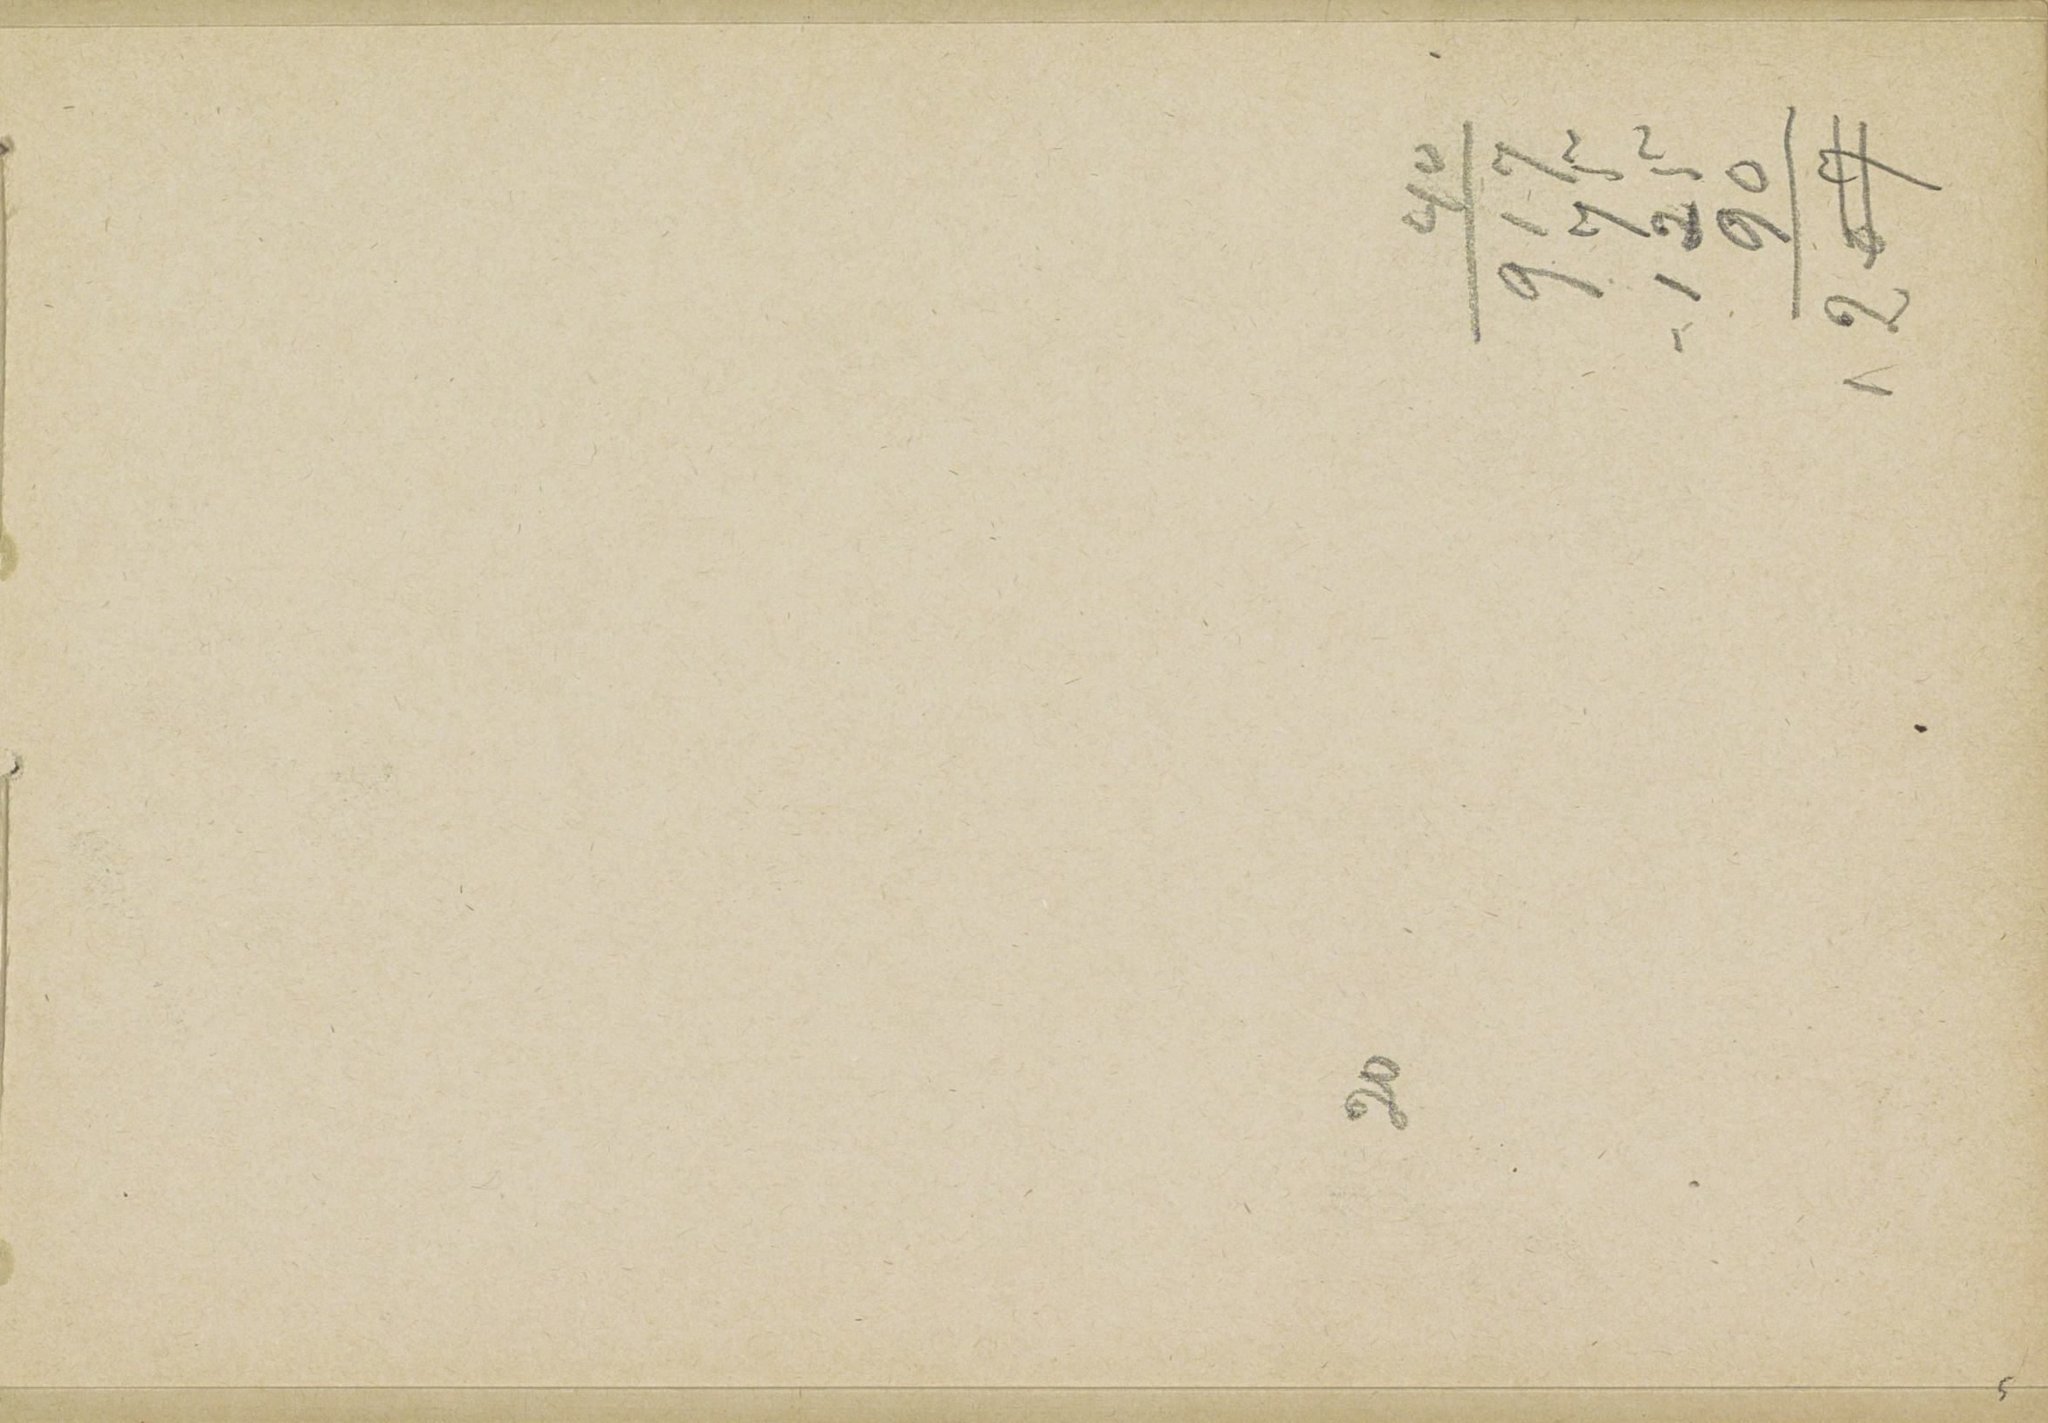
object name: sketchbook leaf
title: Optselsom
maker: willem witsen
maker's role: draughtsman, painter, print maker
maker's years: 1860-1923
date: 1887-1920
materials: paper, pencil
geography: amsterdam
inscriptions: annotation: ‘[...]’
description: Pagina 5 uit een schetsboek met 12 bladen.